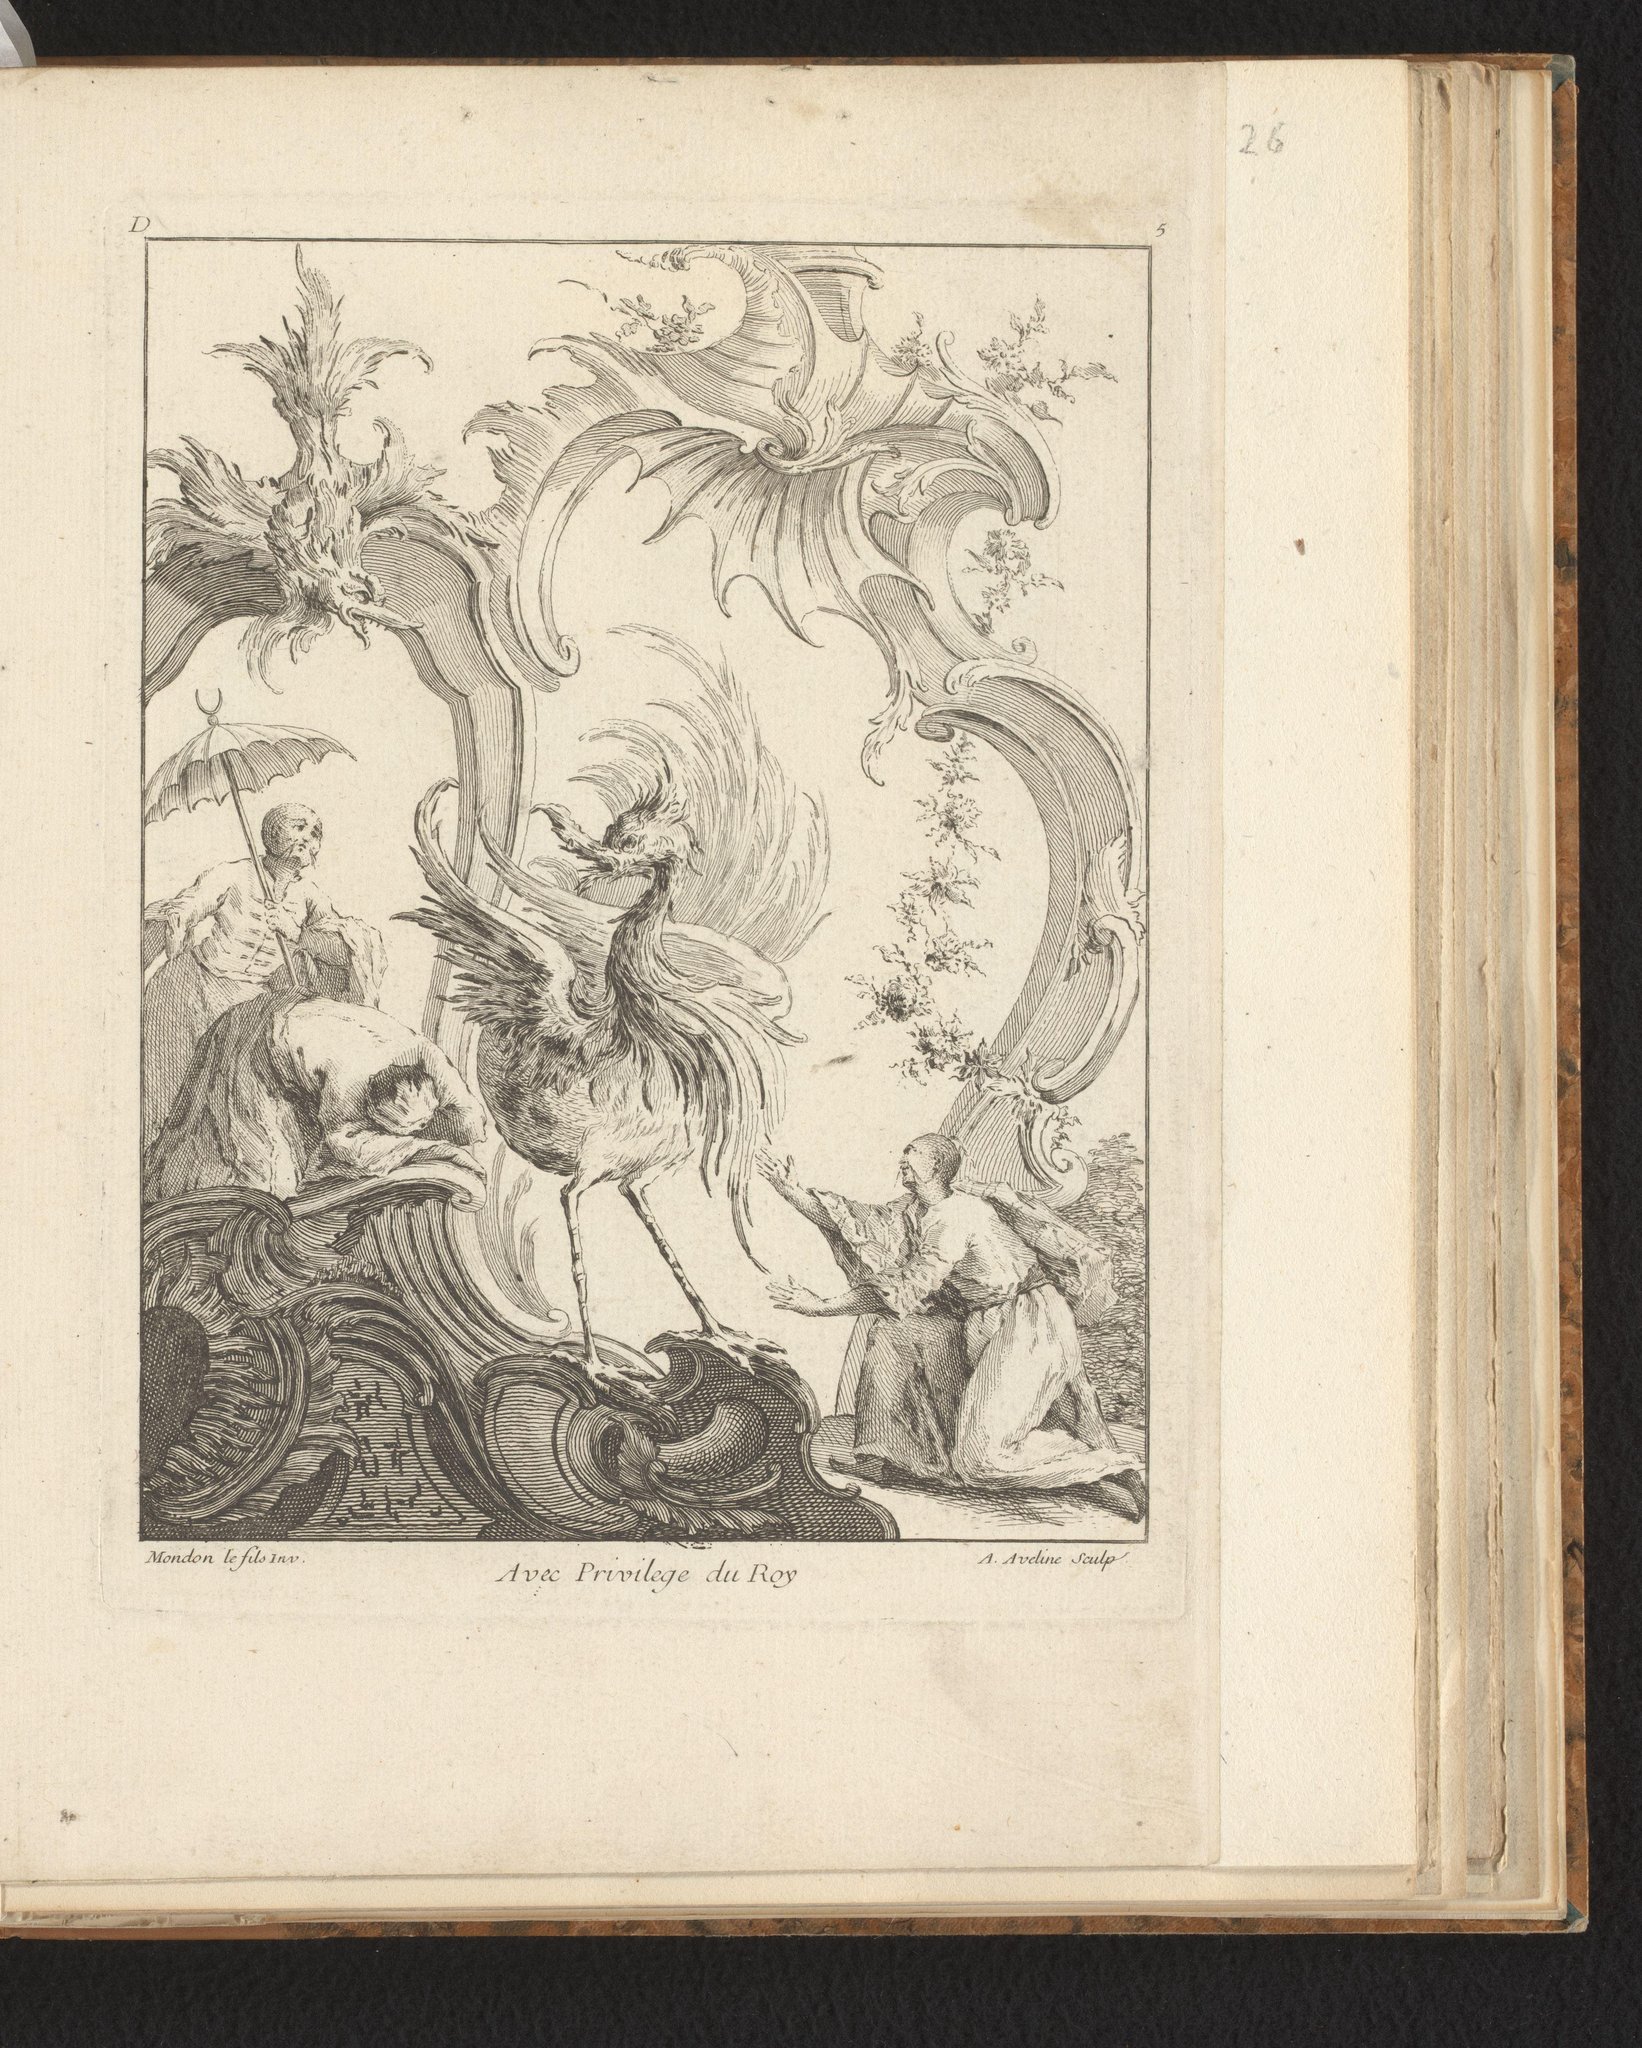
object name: ornament print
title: Quatrième Livre de Formes ornées de Rocailles (...) et Dragons Chinois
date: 1736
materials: paper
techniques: etching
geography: france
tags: rocaille ornament, chinese, fabulous animals ~ birds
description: Deze serie is linksboven genummerd met een letter D. Prent maakt deel uit van een album.